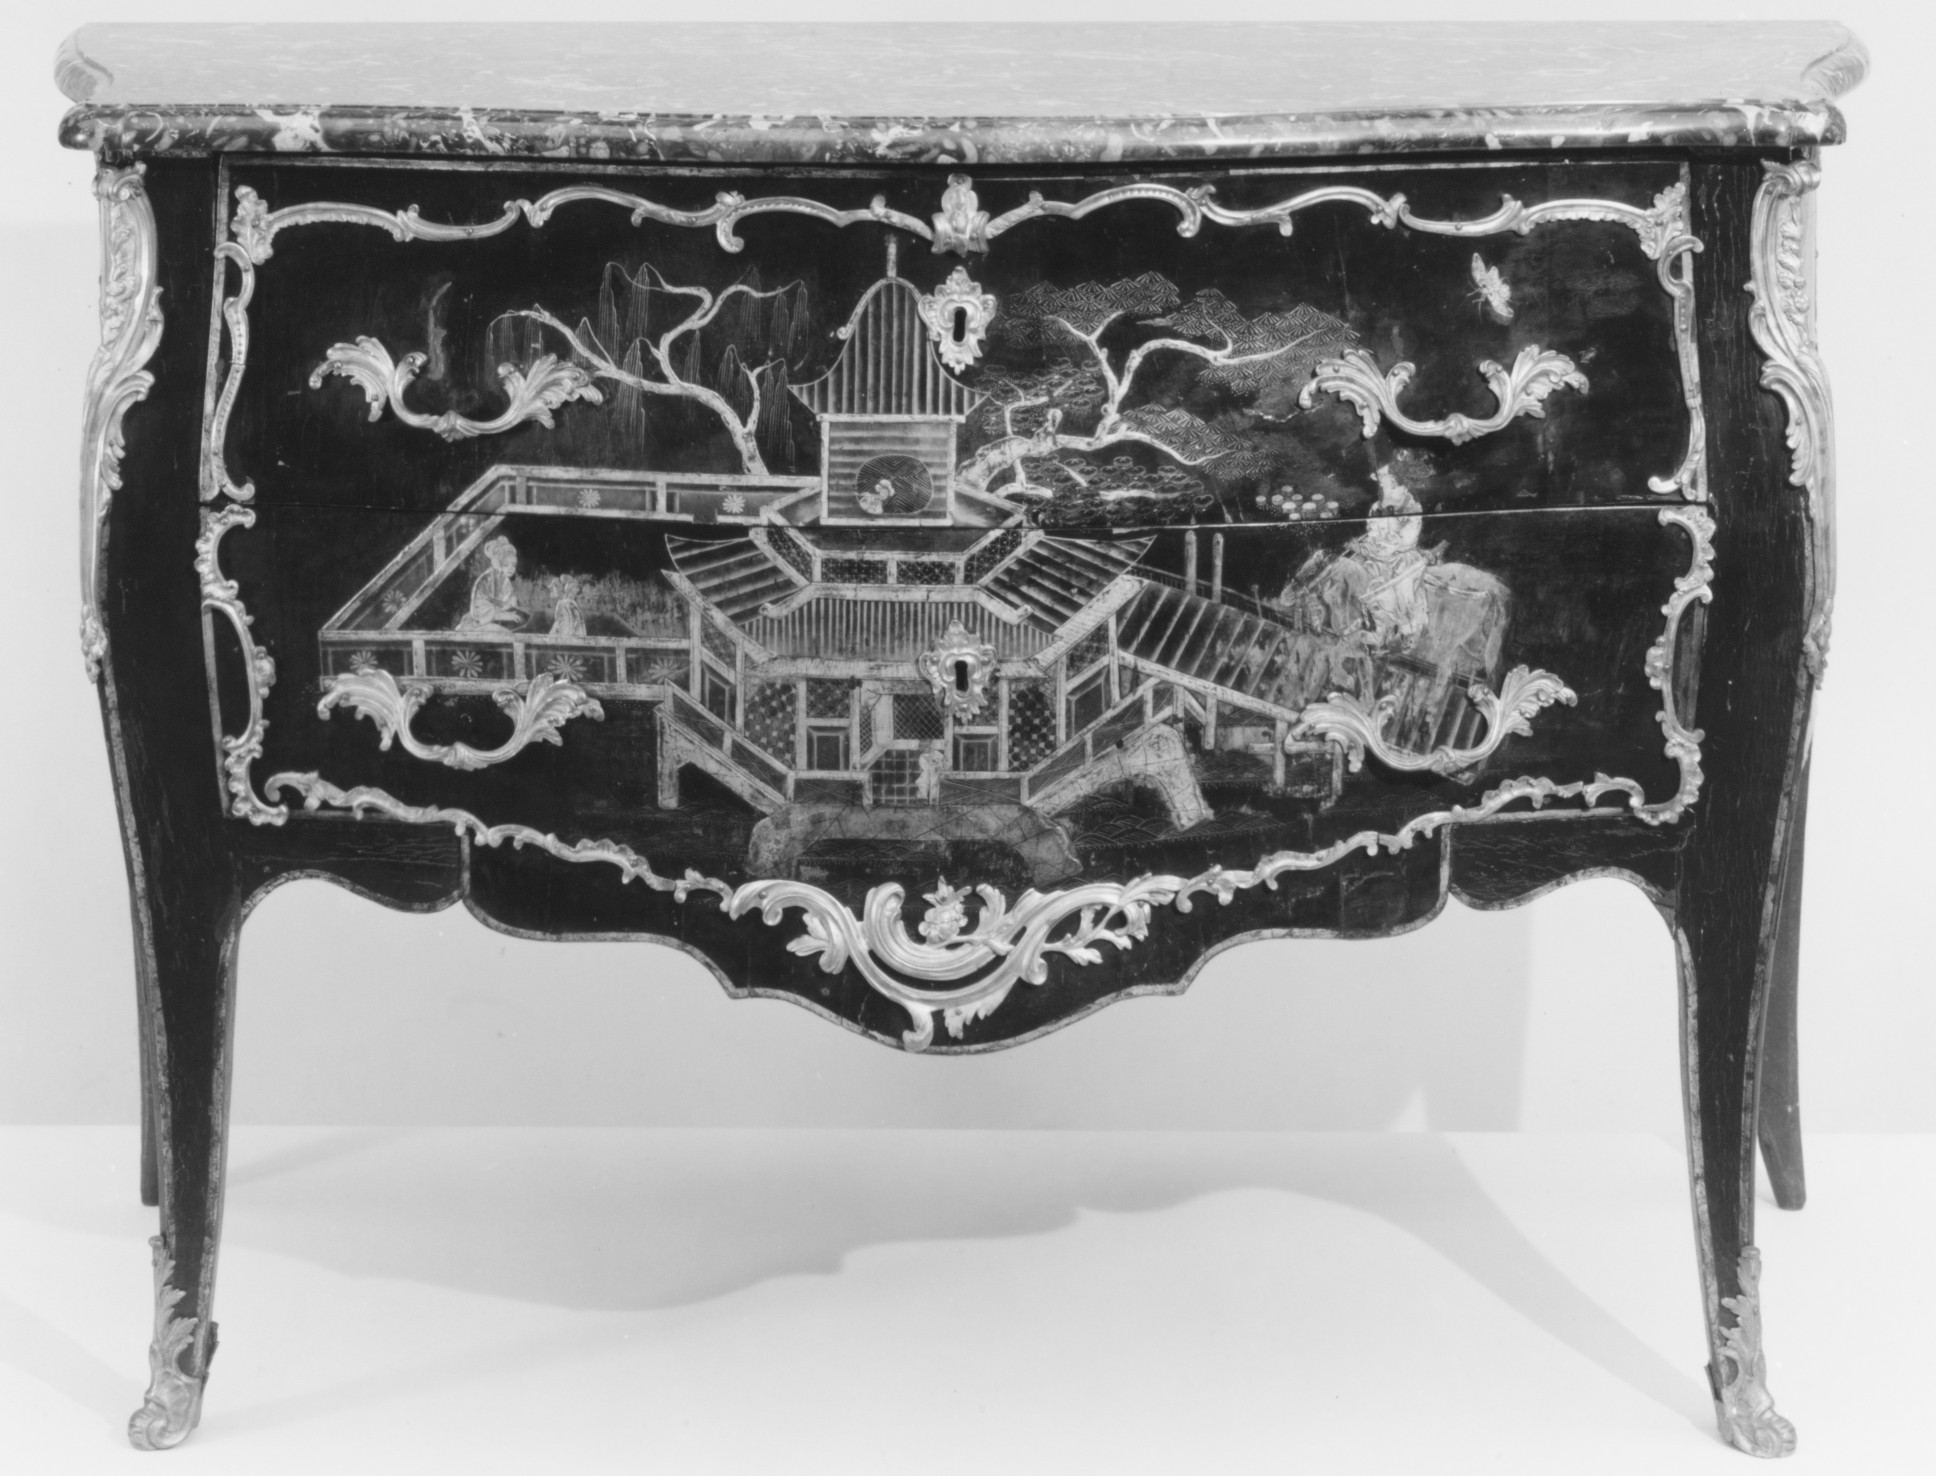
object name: commode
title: Pair of commodes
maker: françois rübestuck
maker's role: maker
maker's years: 1722-1785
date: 1767-1770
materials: gilt bronze, gold, marble, wood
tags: chinoiserie,pavilions